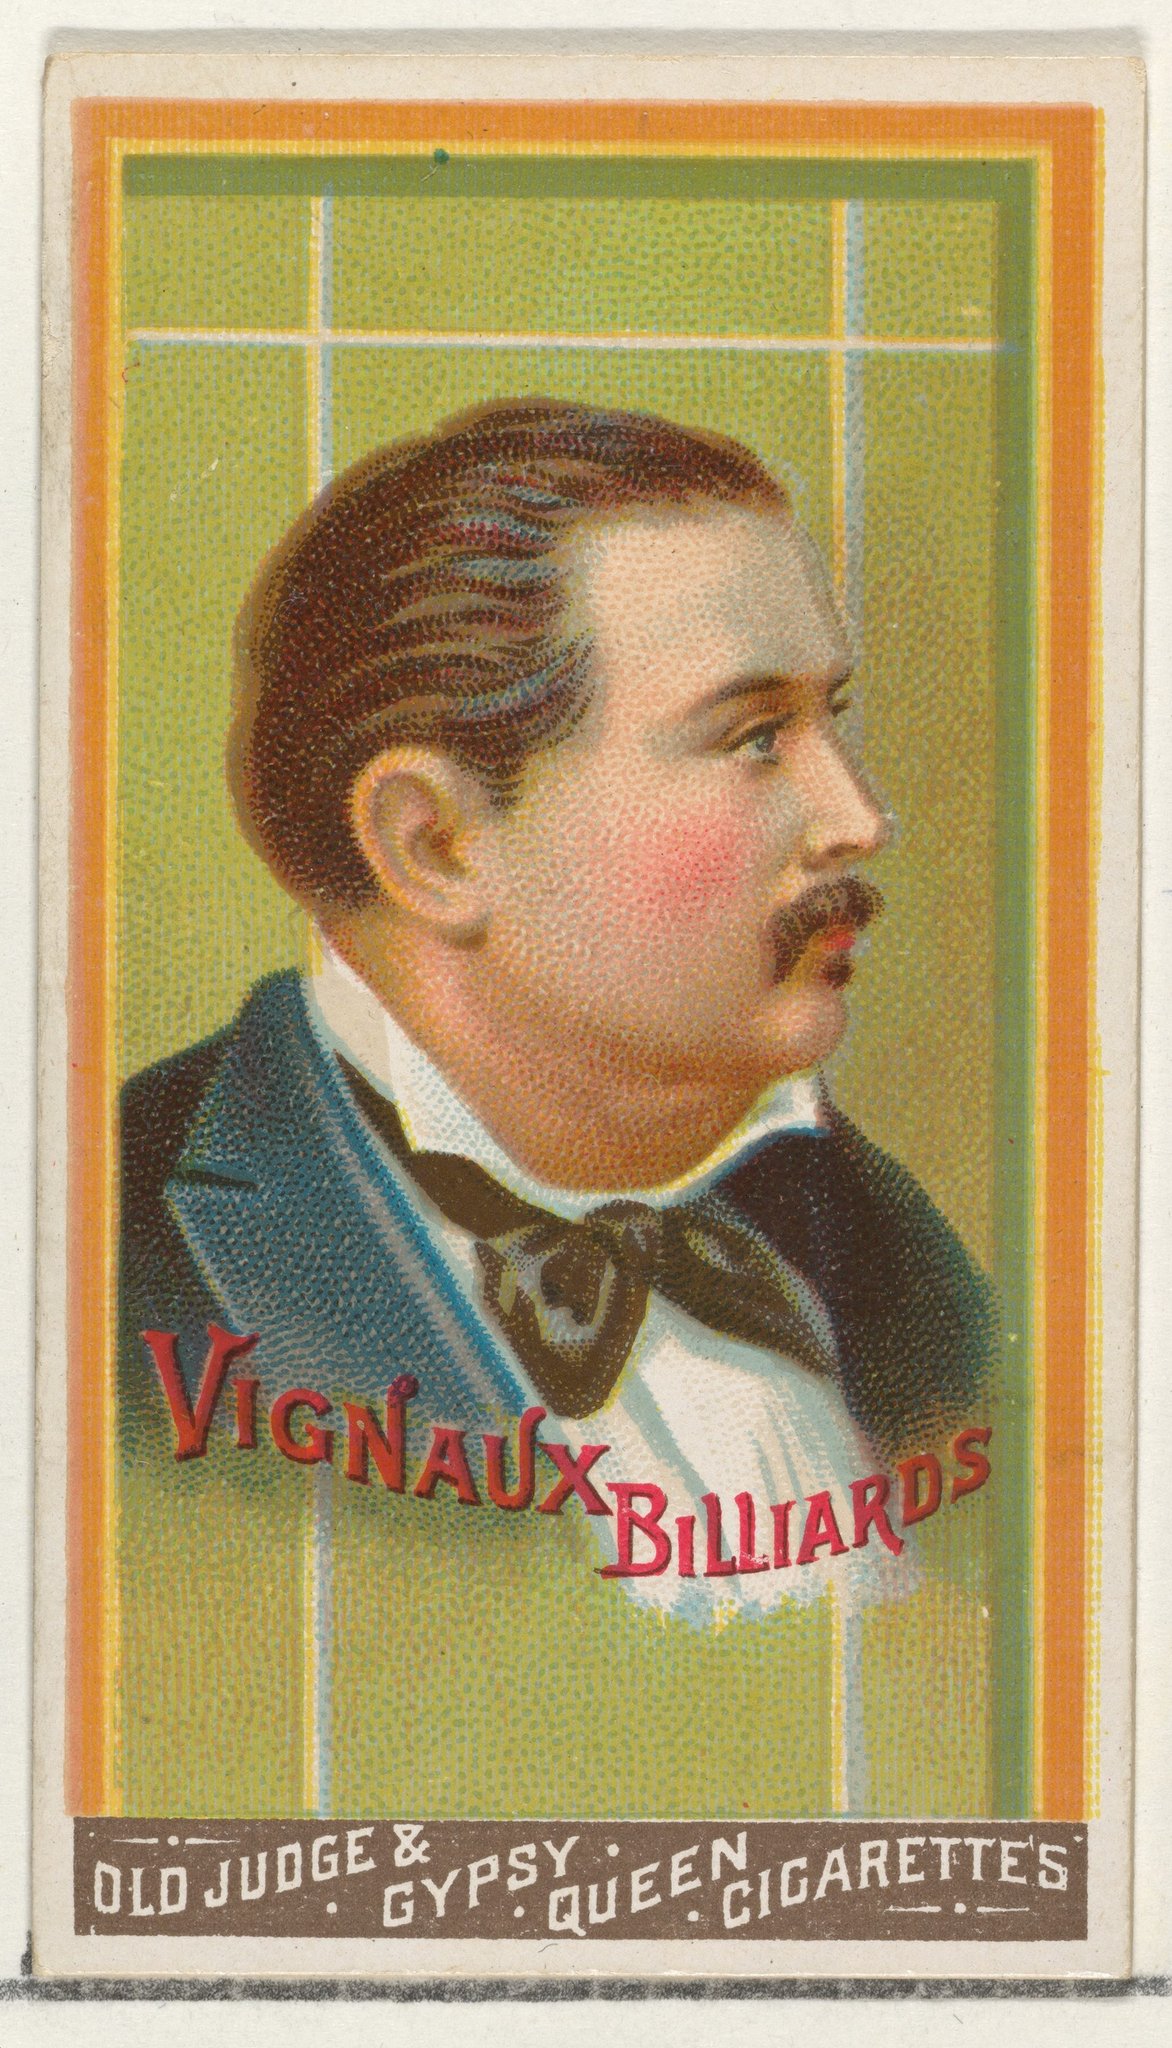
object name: print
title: Vignaux, Billiards, from the Goodwin Champion series for Old Judge and Gypsy Queen Cigarettes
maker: goodwin & company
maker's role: publisher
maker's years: 1850-1950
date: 1888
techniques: color lithograph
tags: men,profiles,sports,athletes